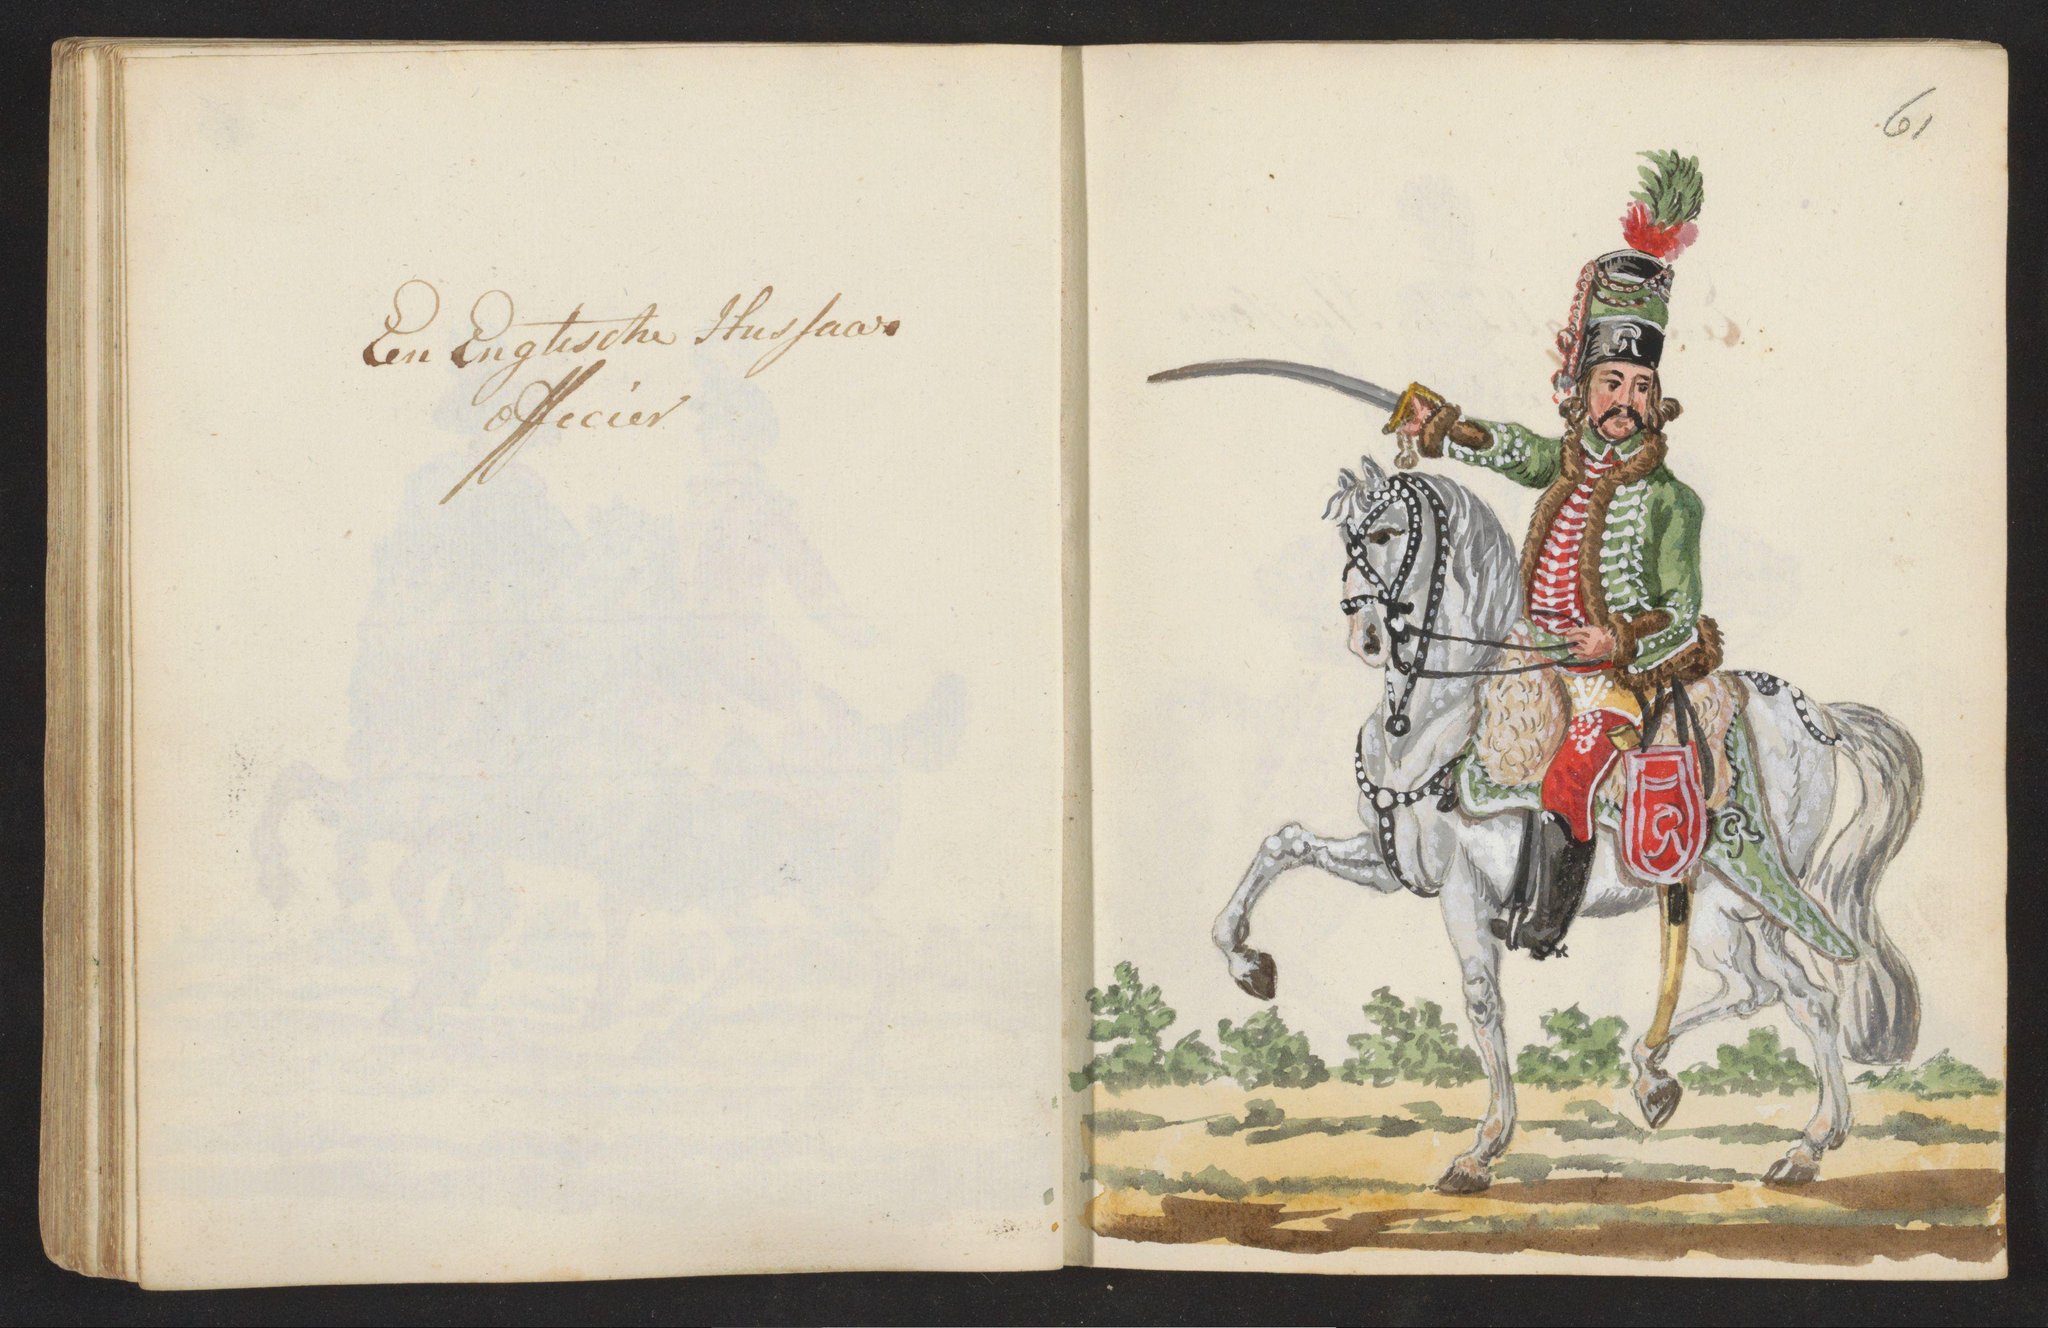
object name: drawing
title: Uniform van Engelse huzaar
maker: s.g. casten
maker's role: draughtsman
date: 1795-1796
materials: paper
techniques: writing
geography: amsterdam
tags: (military) uniforms (+ cavalry, horsemen), patriots (1780-1795)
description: Het uniform van een Engelse huzaar, ca. 1788-1795. Onderdeel van het derde hoofdstuk over de nieuwe uniformen in de periode na het herstel van de prins van Oranje en de komst van de Pruisische troepen in Holland in 1787. In het schetsboek met gekleurde tekeningen van de uniformen van militairen en leden van de schutterij uit de periode 1770 tot 1795-1796.